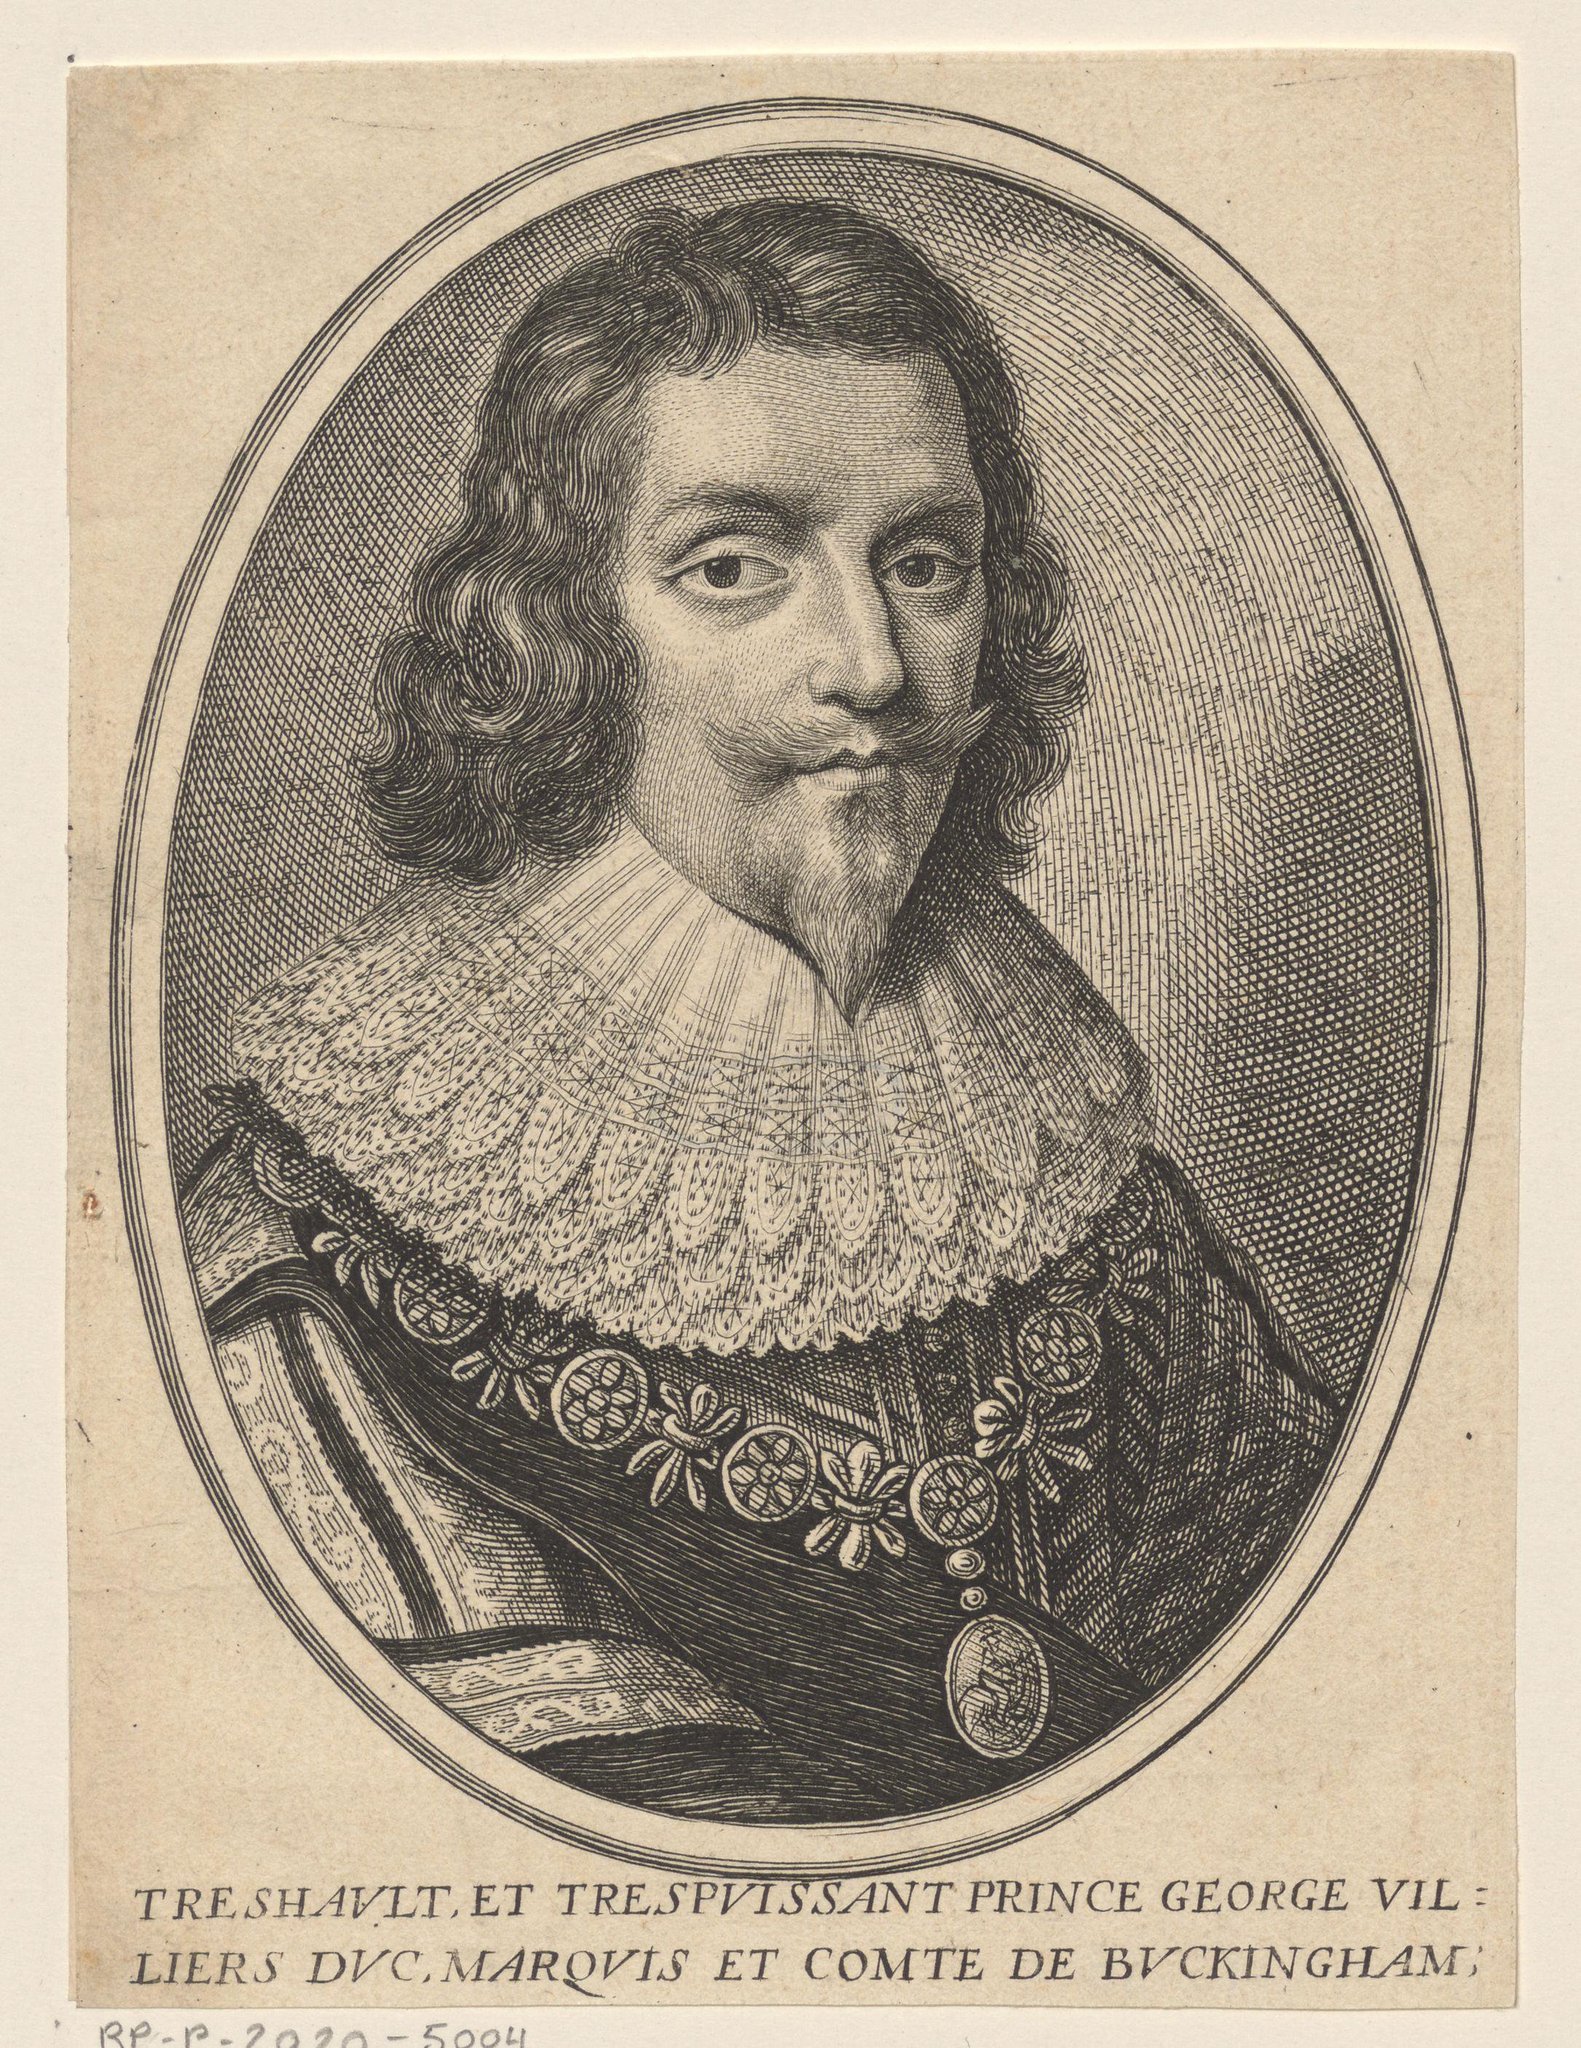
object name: print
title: Portret van George Villiers, hertog van Buckingham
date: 1625-1668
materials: paper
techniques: engraving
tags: george villiers (1st duke of buckingham), historical persons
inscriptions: collector's mark: Lugt 2228